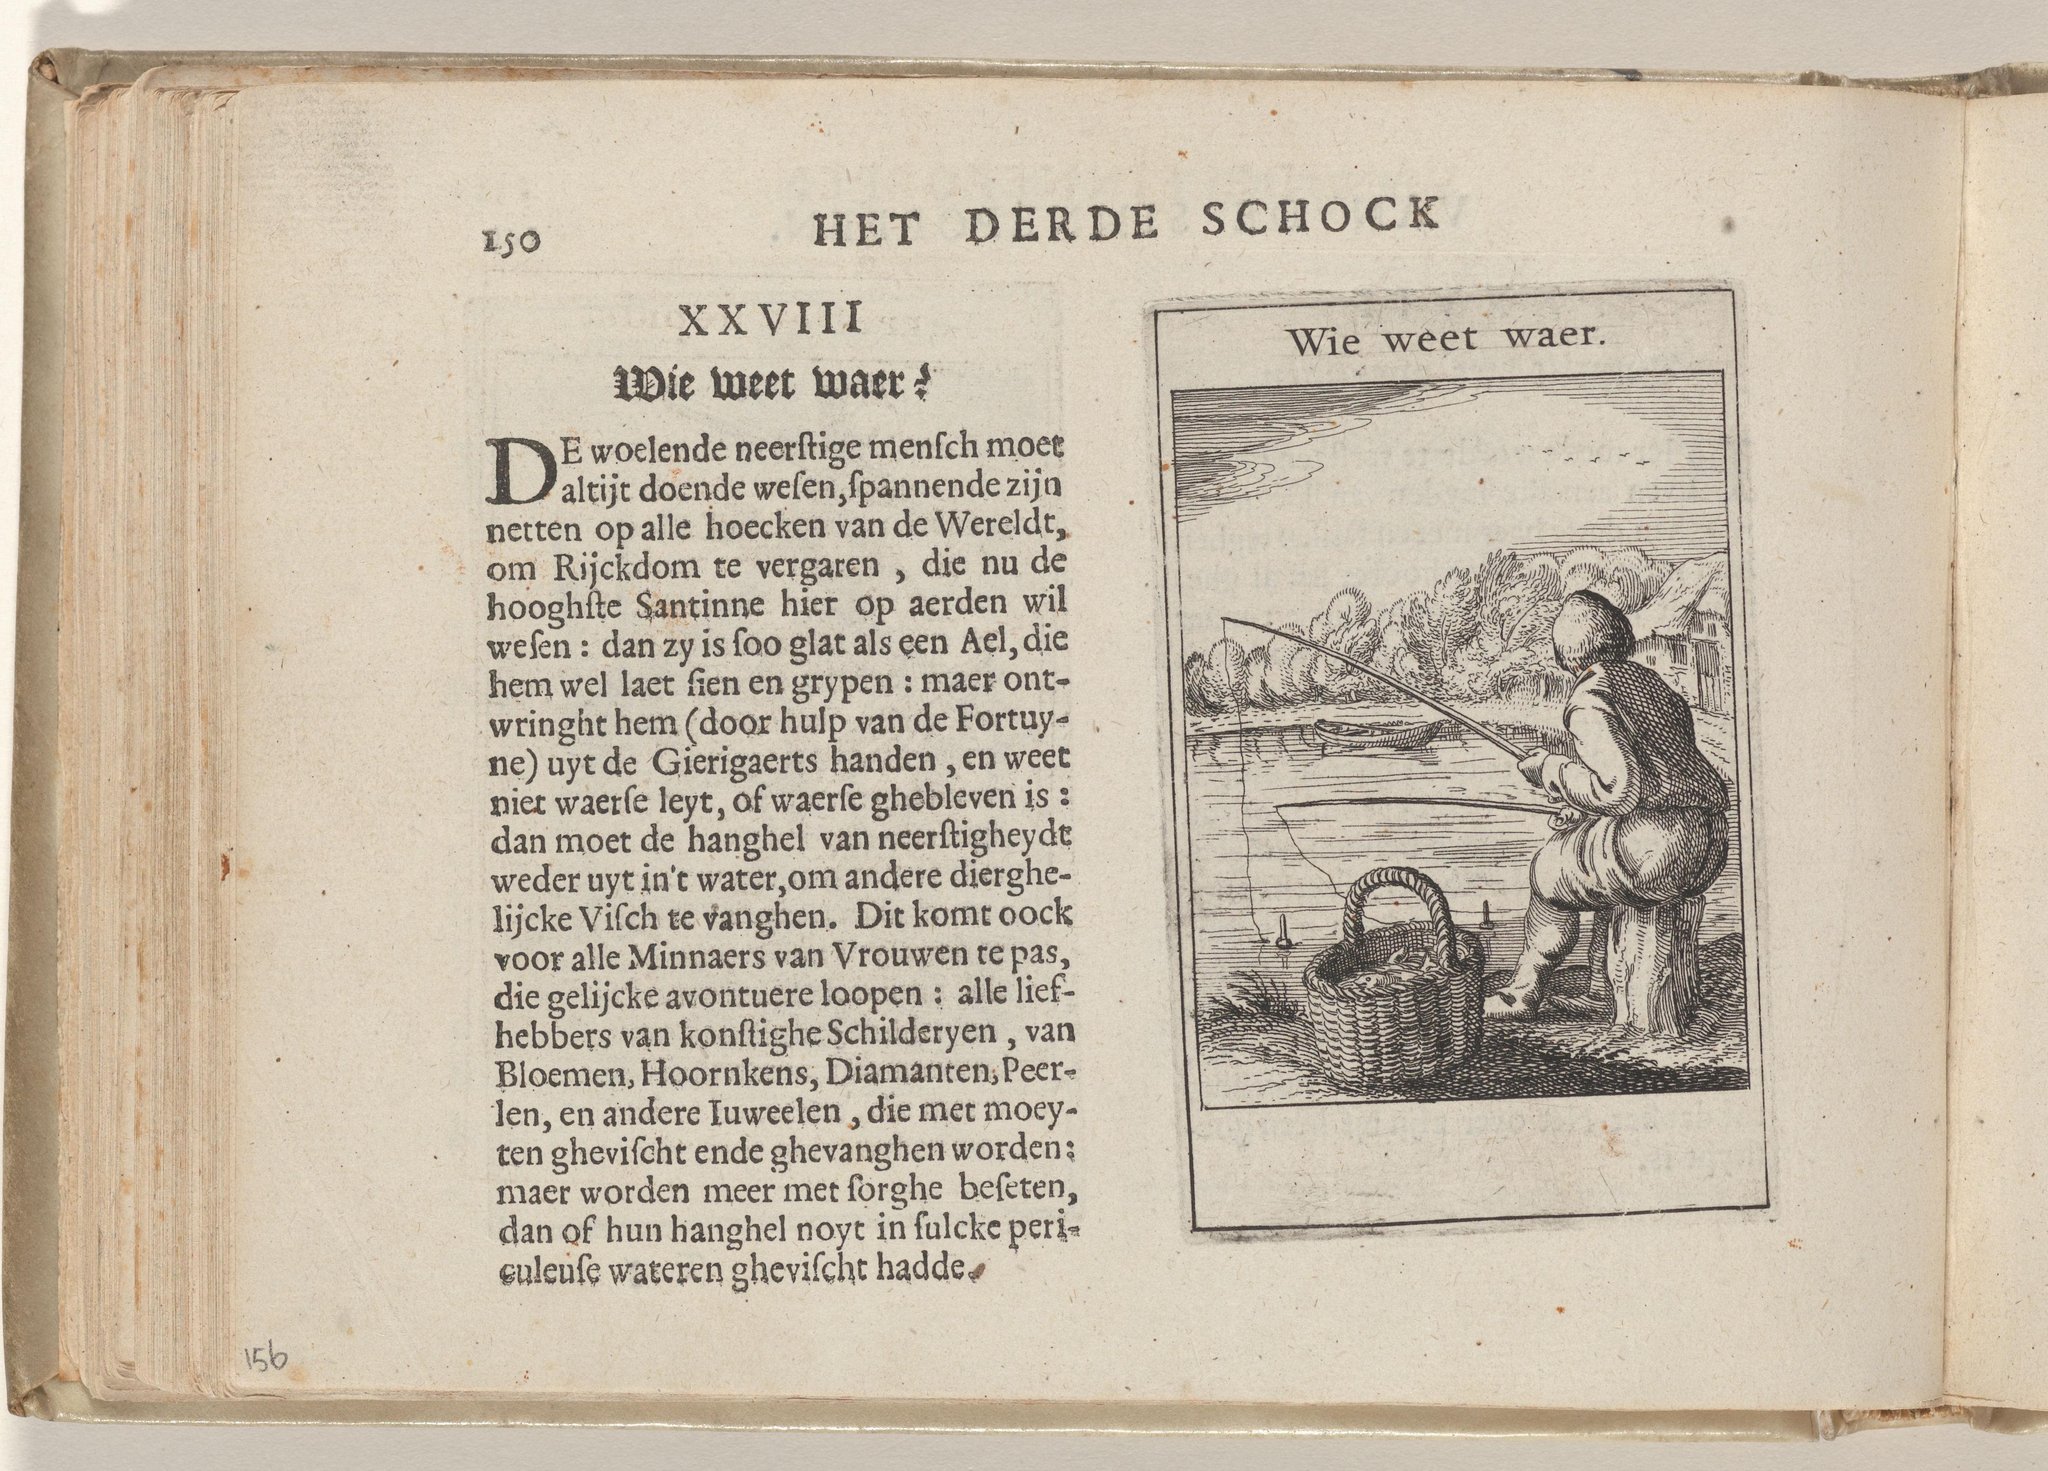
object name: album leaf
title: XXVIII Wie weet waer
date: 1614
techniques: engraving, printing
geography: the hague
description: XXVIII Wie weet waer. Derde schok. Onderdeel van 'Sinnepoppen', R. Visscher, 1614.